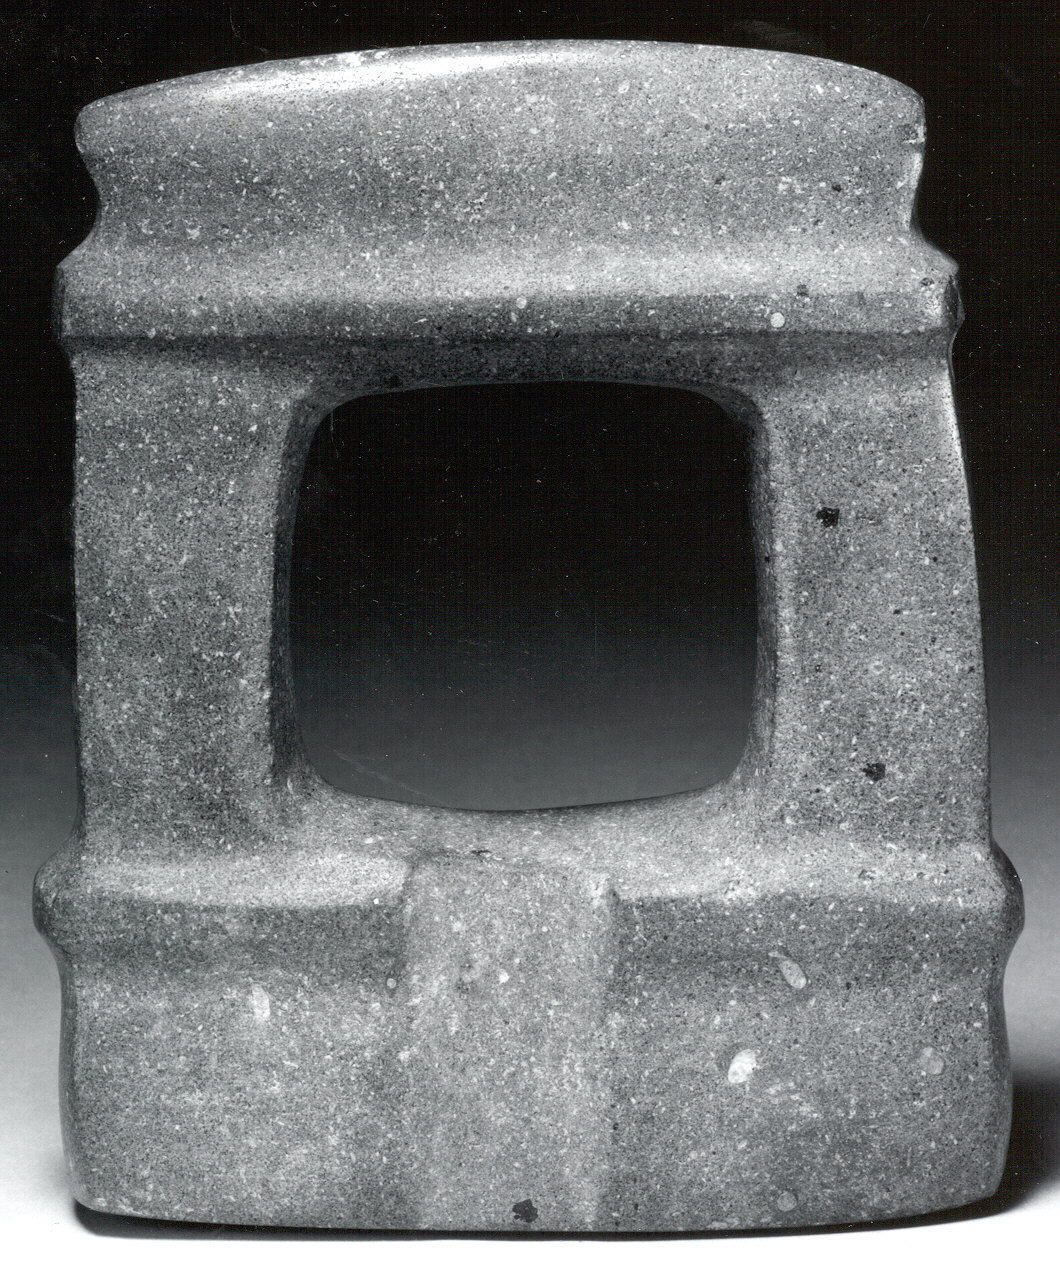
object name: architectural model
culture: mezcala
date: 1-800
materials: stone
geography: mexico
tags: temples